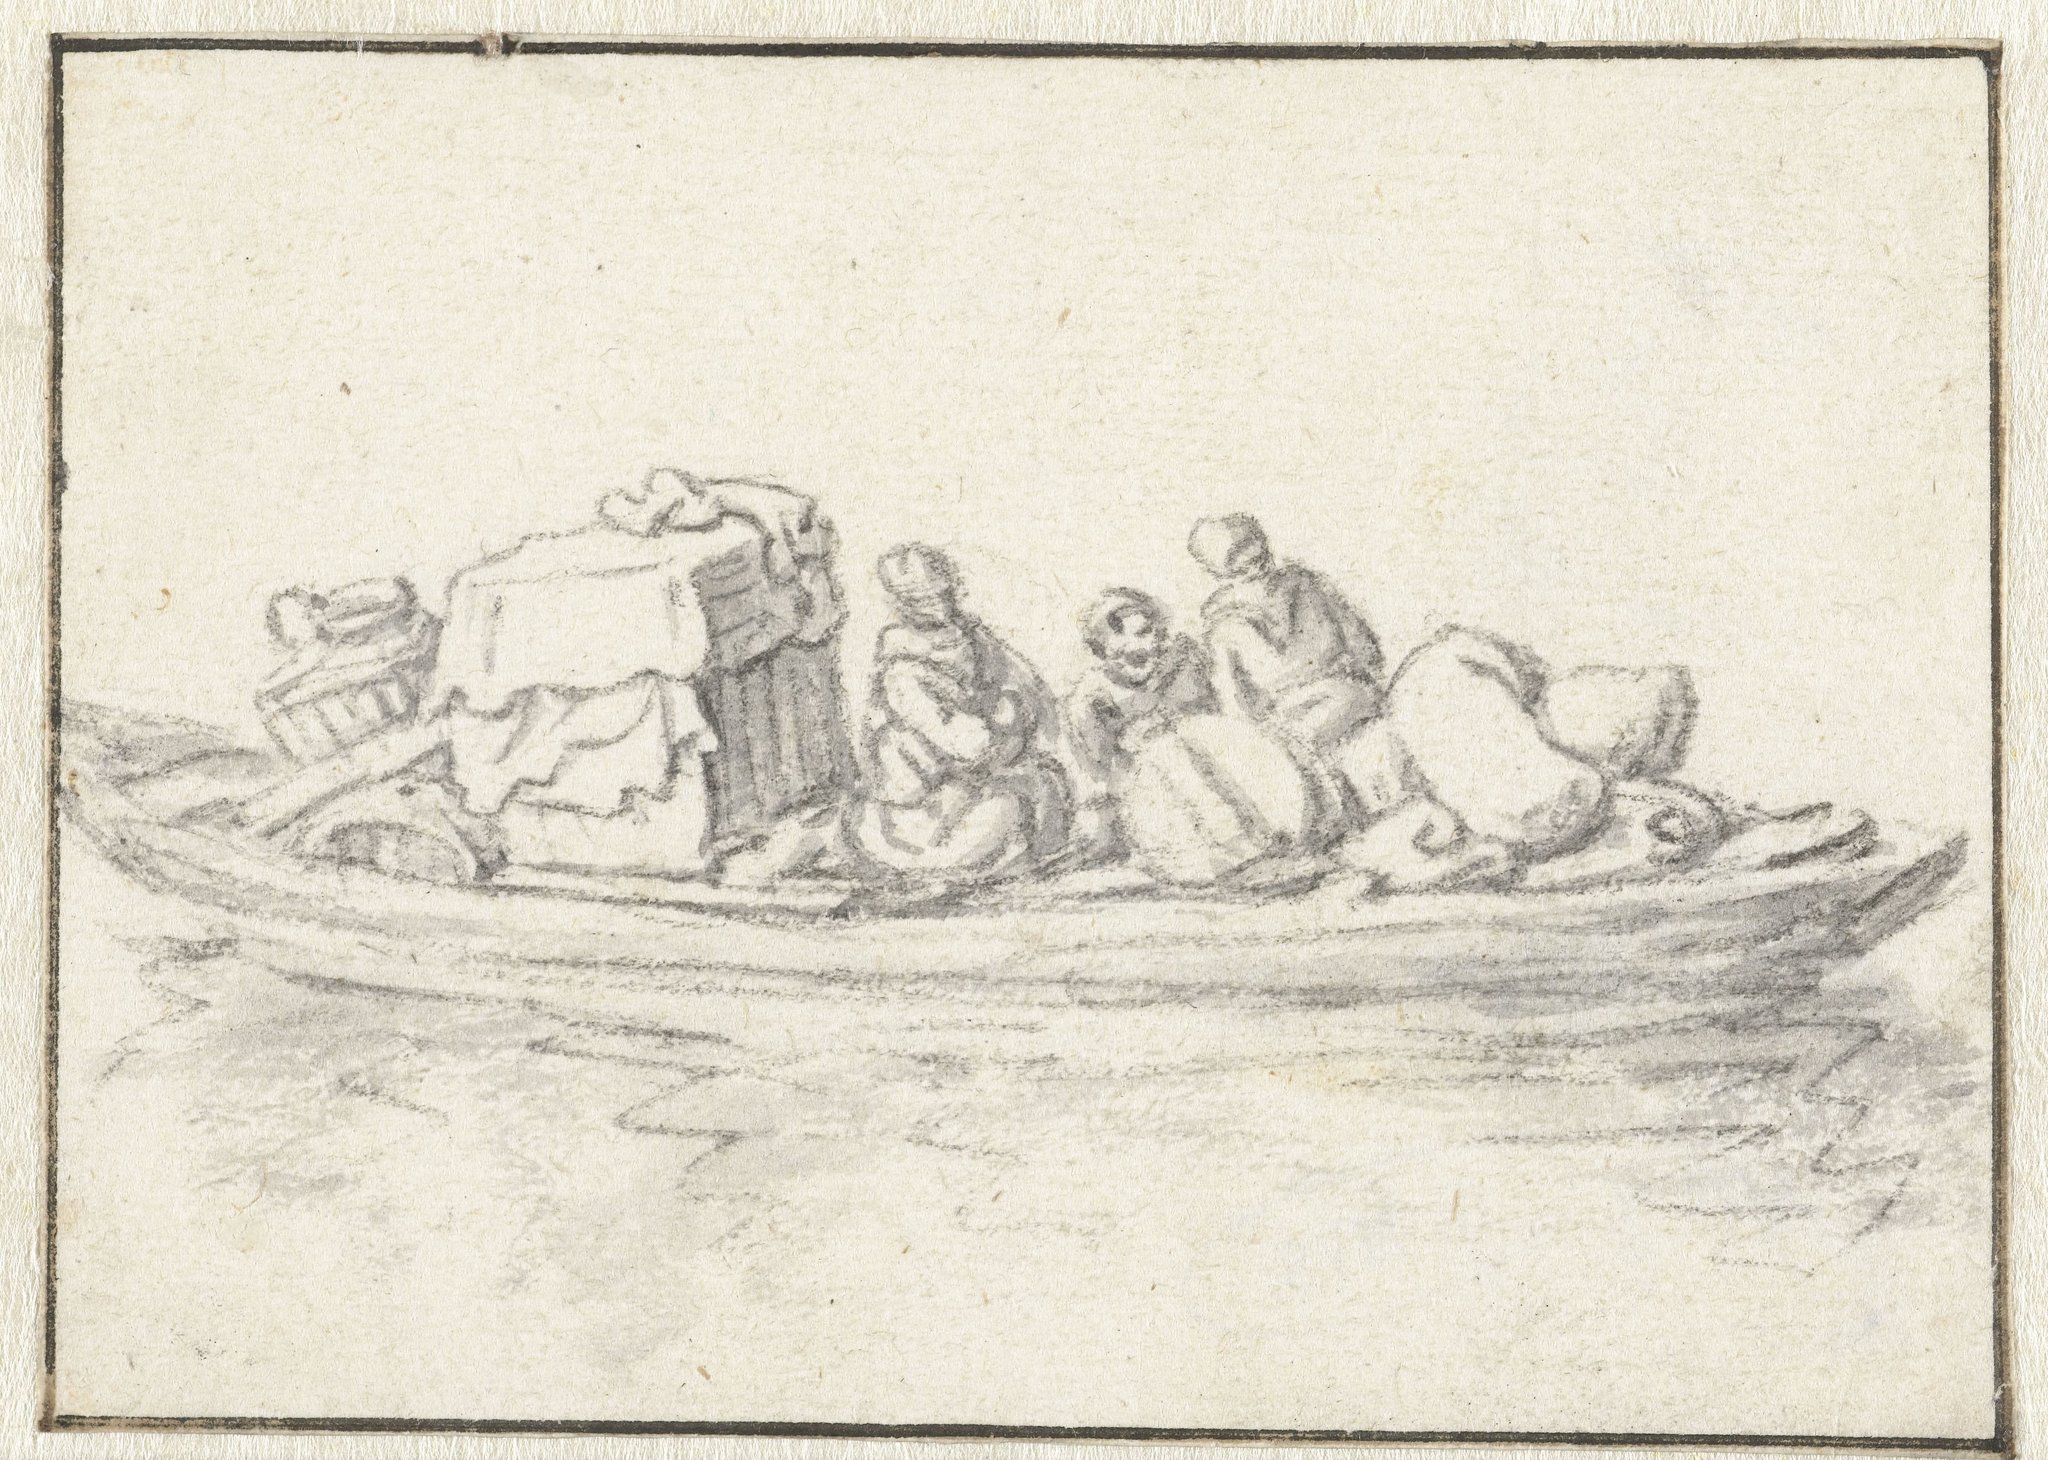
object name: drawing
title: Drie personen in een schuit beladen met huisraad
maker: herman saftleven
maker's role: draughtsman, painter, print maker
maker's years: 1609-1685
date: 1619-1685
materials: chalk, paper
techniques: brush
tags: passengers ~ ship, oaring, sculling